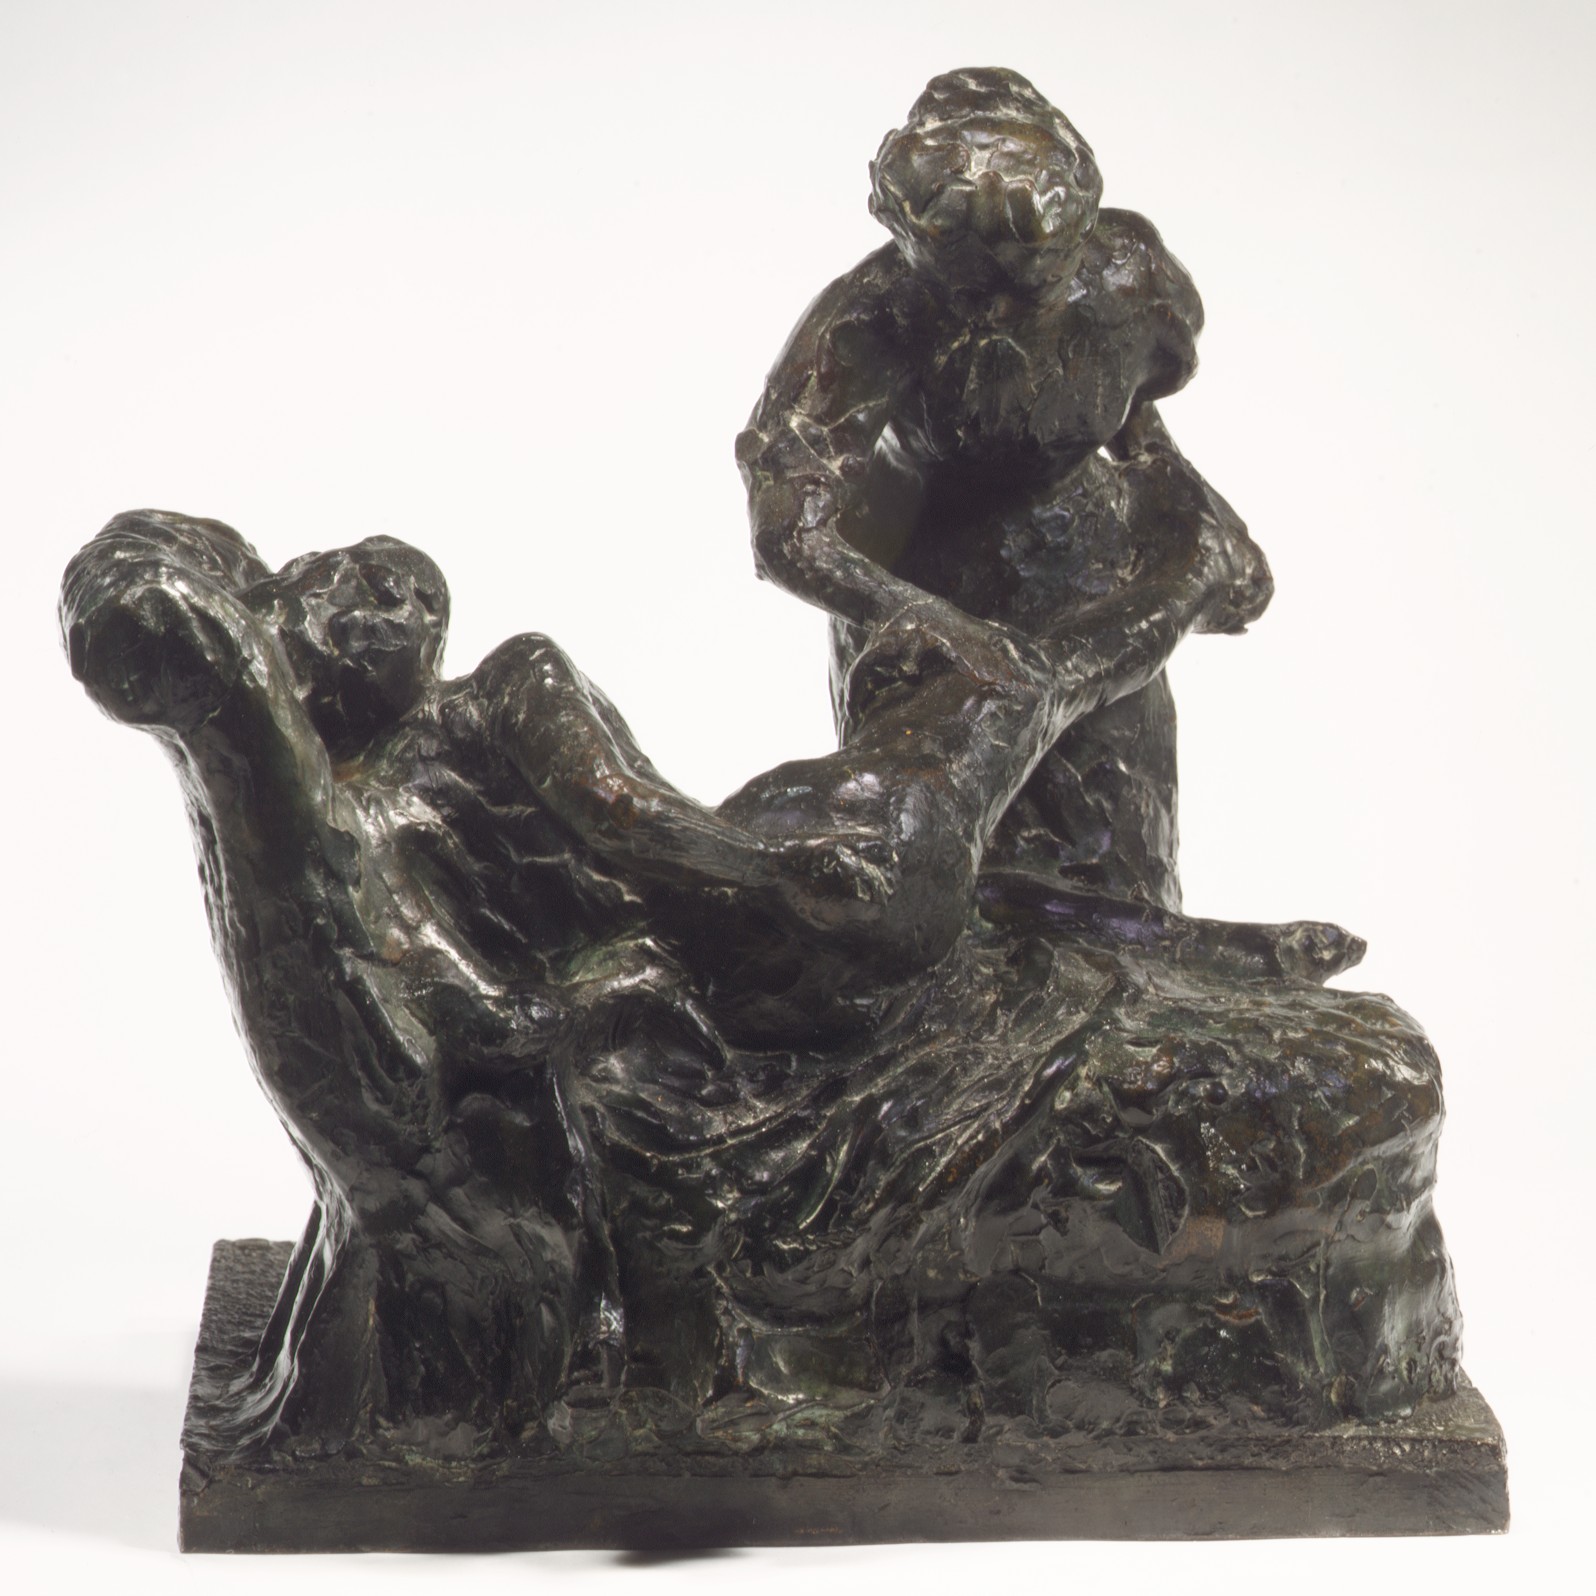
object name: statuette group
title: La Masseuse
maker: edgar degas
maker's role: artist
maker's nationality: french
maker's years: 1834-1917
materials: bronze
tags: human figures